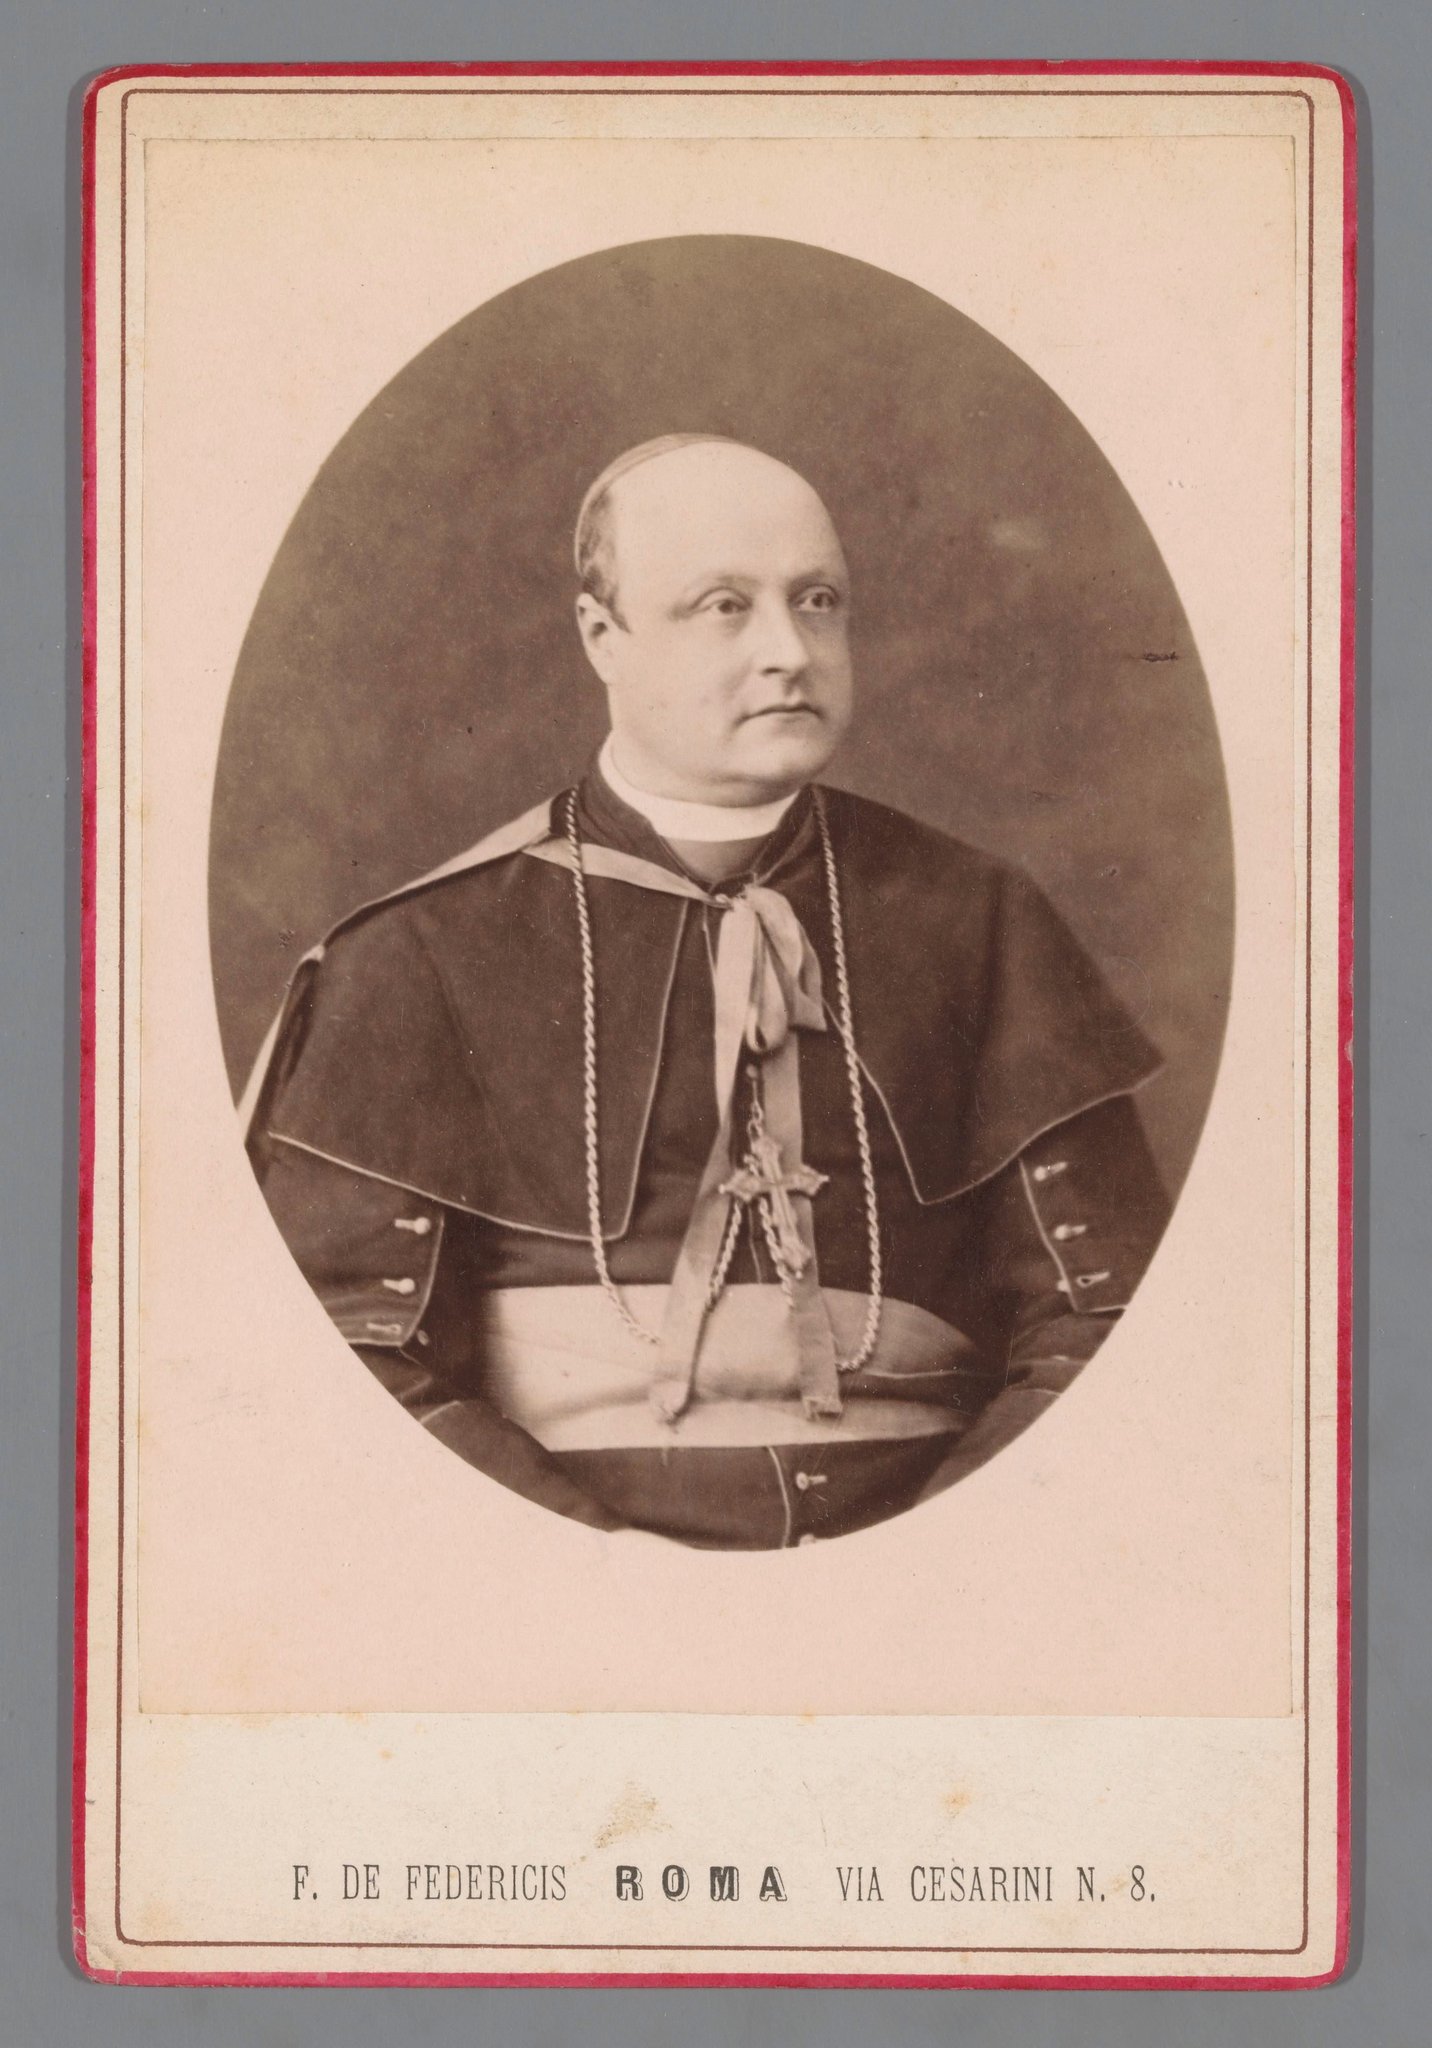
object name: cabinet photograph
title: Portret van een paus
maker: francesco de federicis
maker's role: fotograaf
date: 1878-1903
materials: cardboard, photographic support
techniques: albumen print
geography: vatican city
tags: pope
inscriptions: name: ‘F. De Federicis Roma Via Cesarini N. 8.’